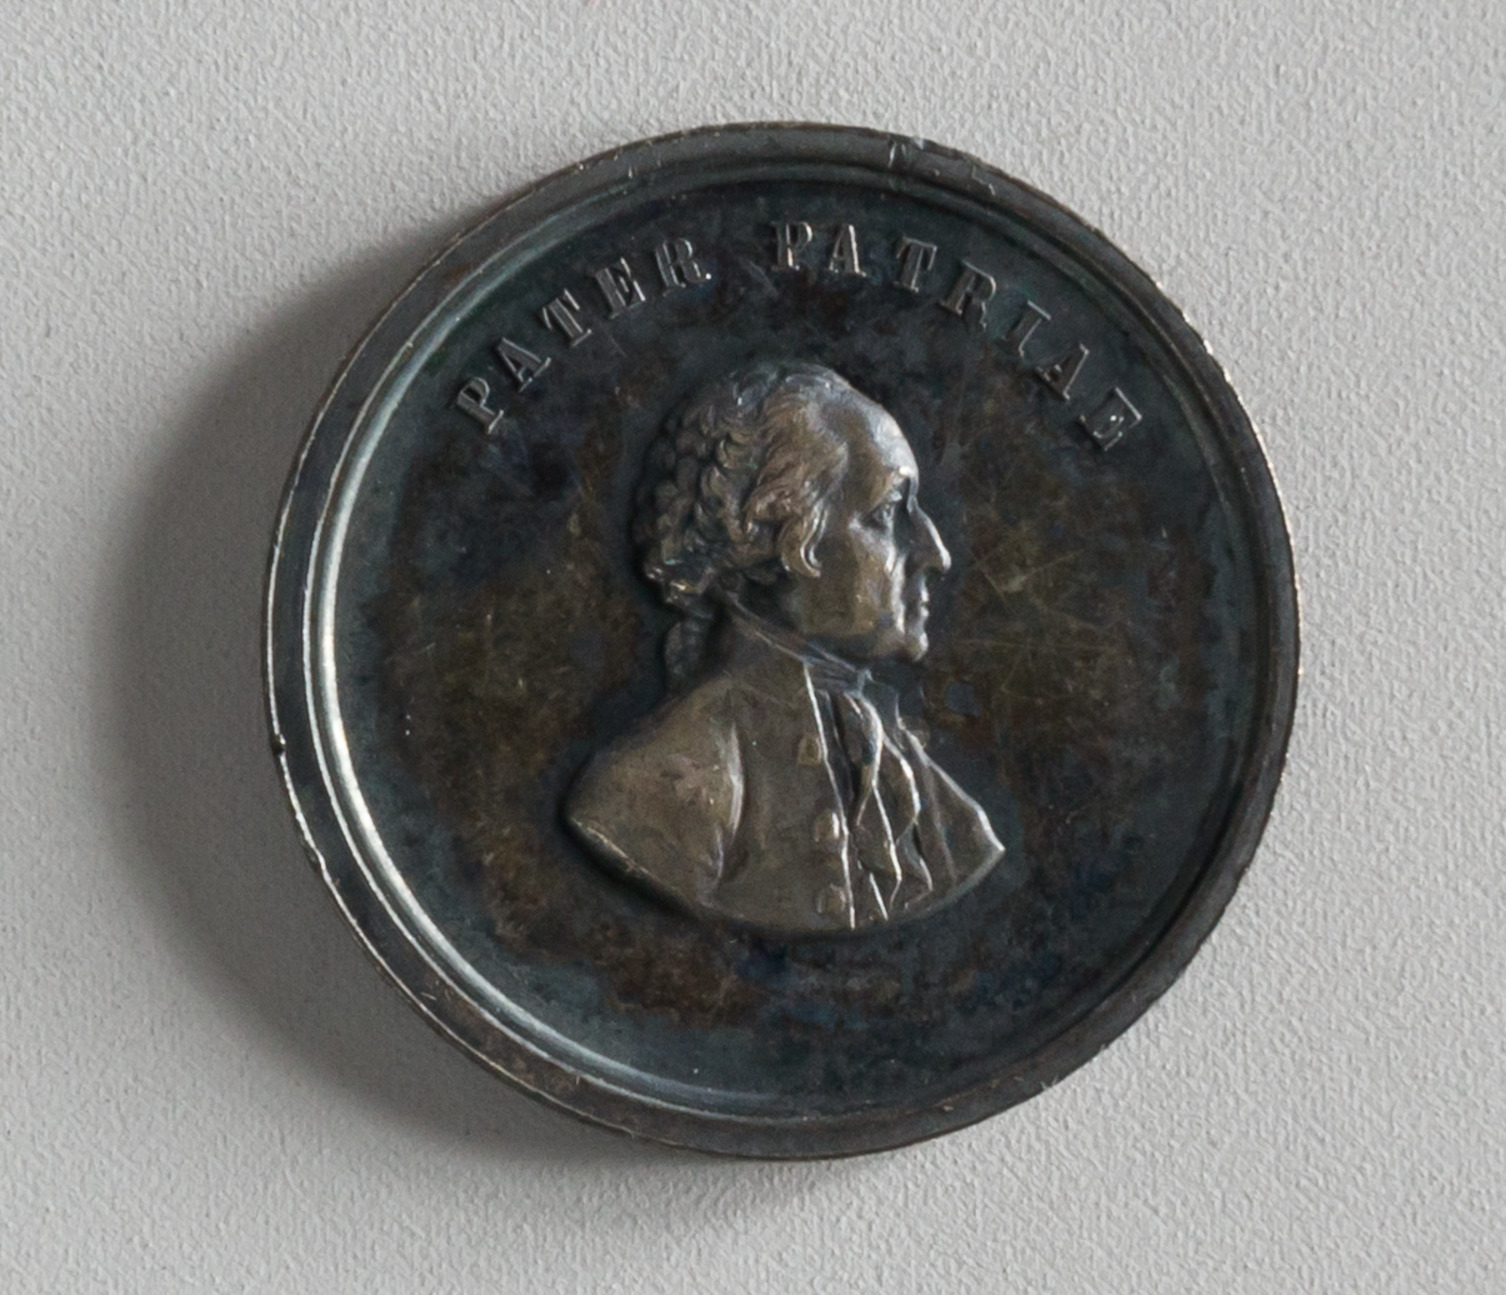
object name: medal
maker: anthony paquet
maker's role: maker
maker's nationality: american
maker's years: 1814-1882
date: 1859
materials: metal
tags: men,profiles